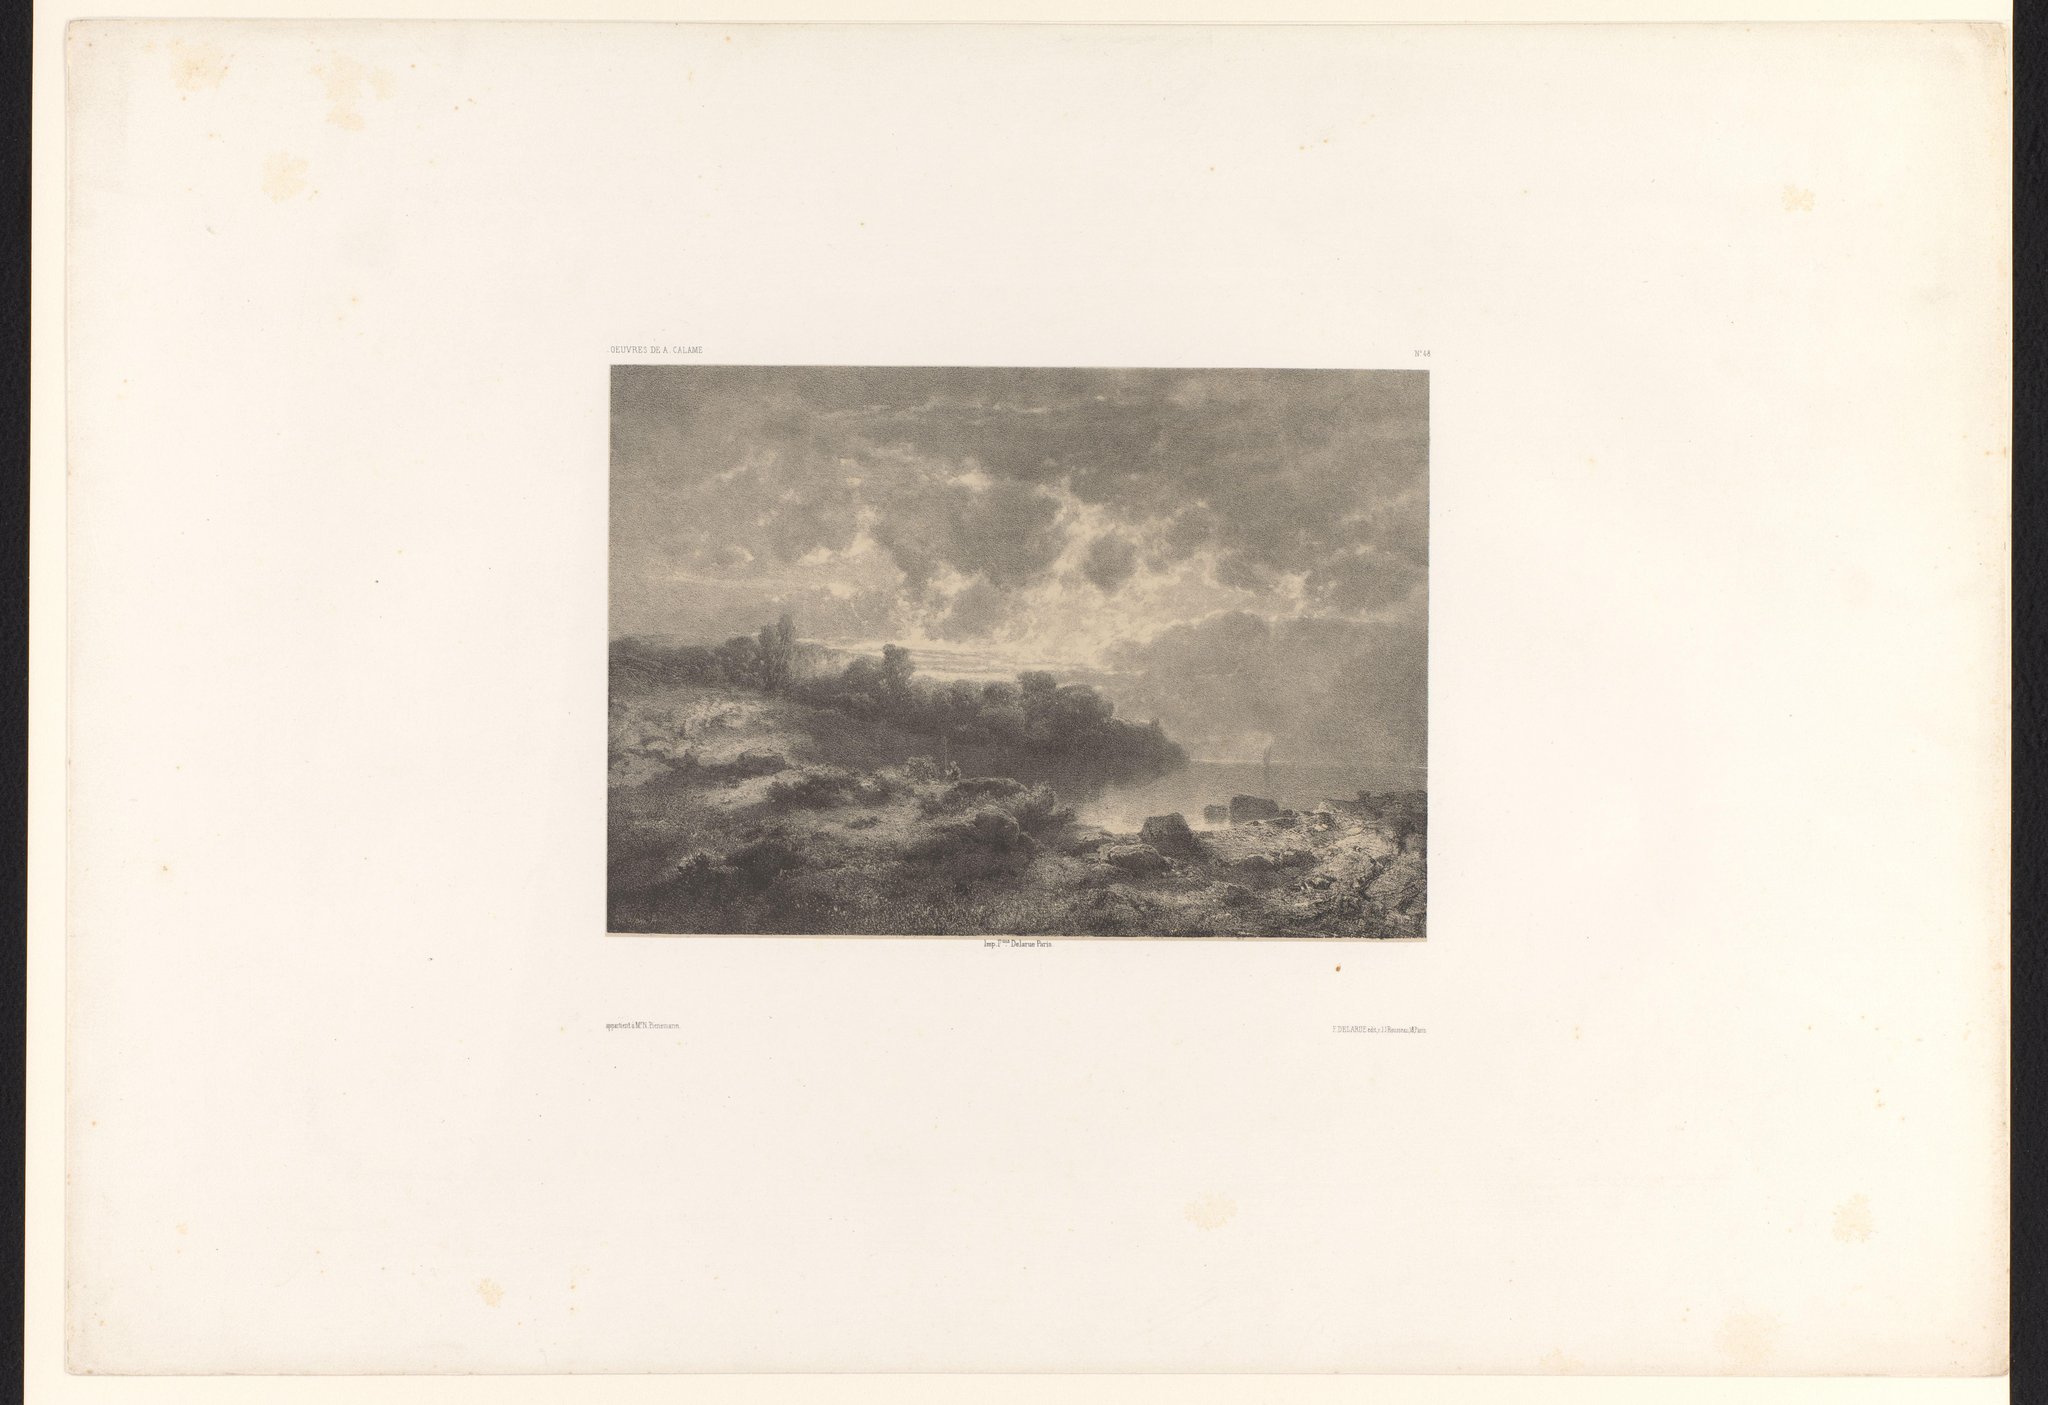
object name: print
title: Oeuvres de A. Calame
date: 1852-1855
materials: paper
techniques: lithograph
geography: paris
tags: low hill country, lake, sunlight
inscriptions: collector's mark: Lugt 2228a